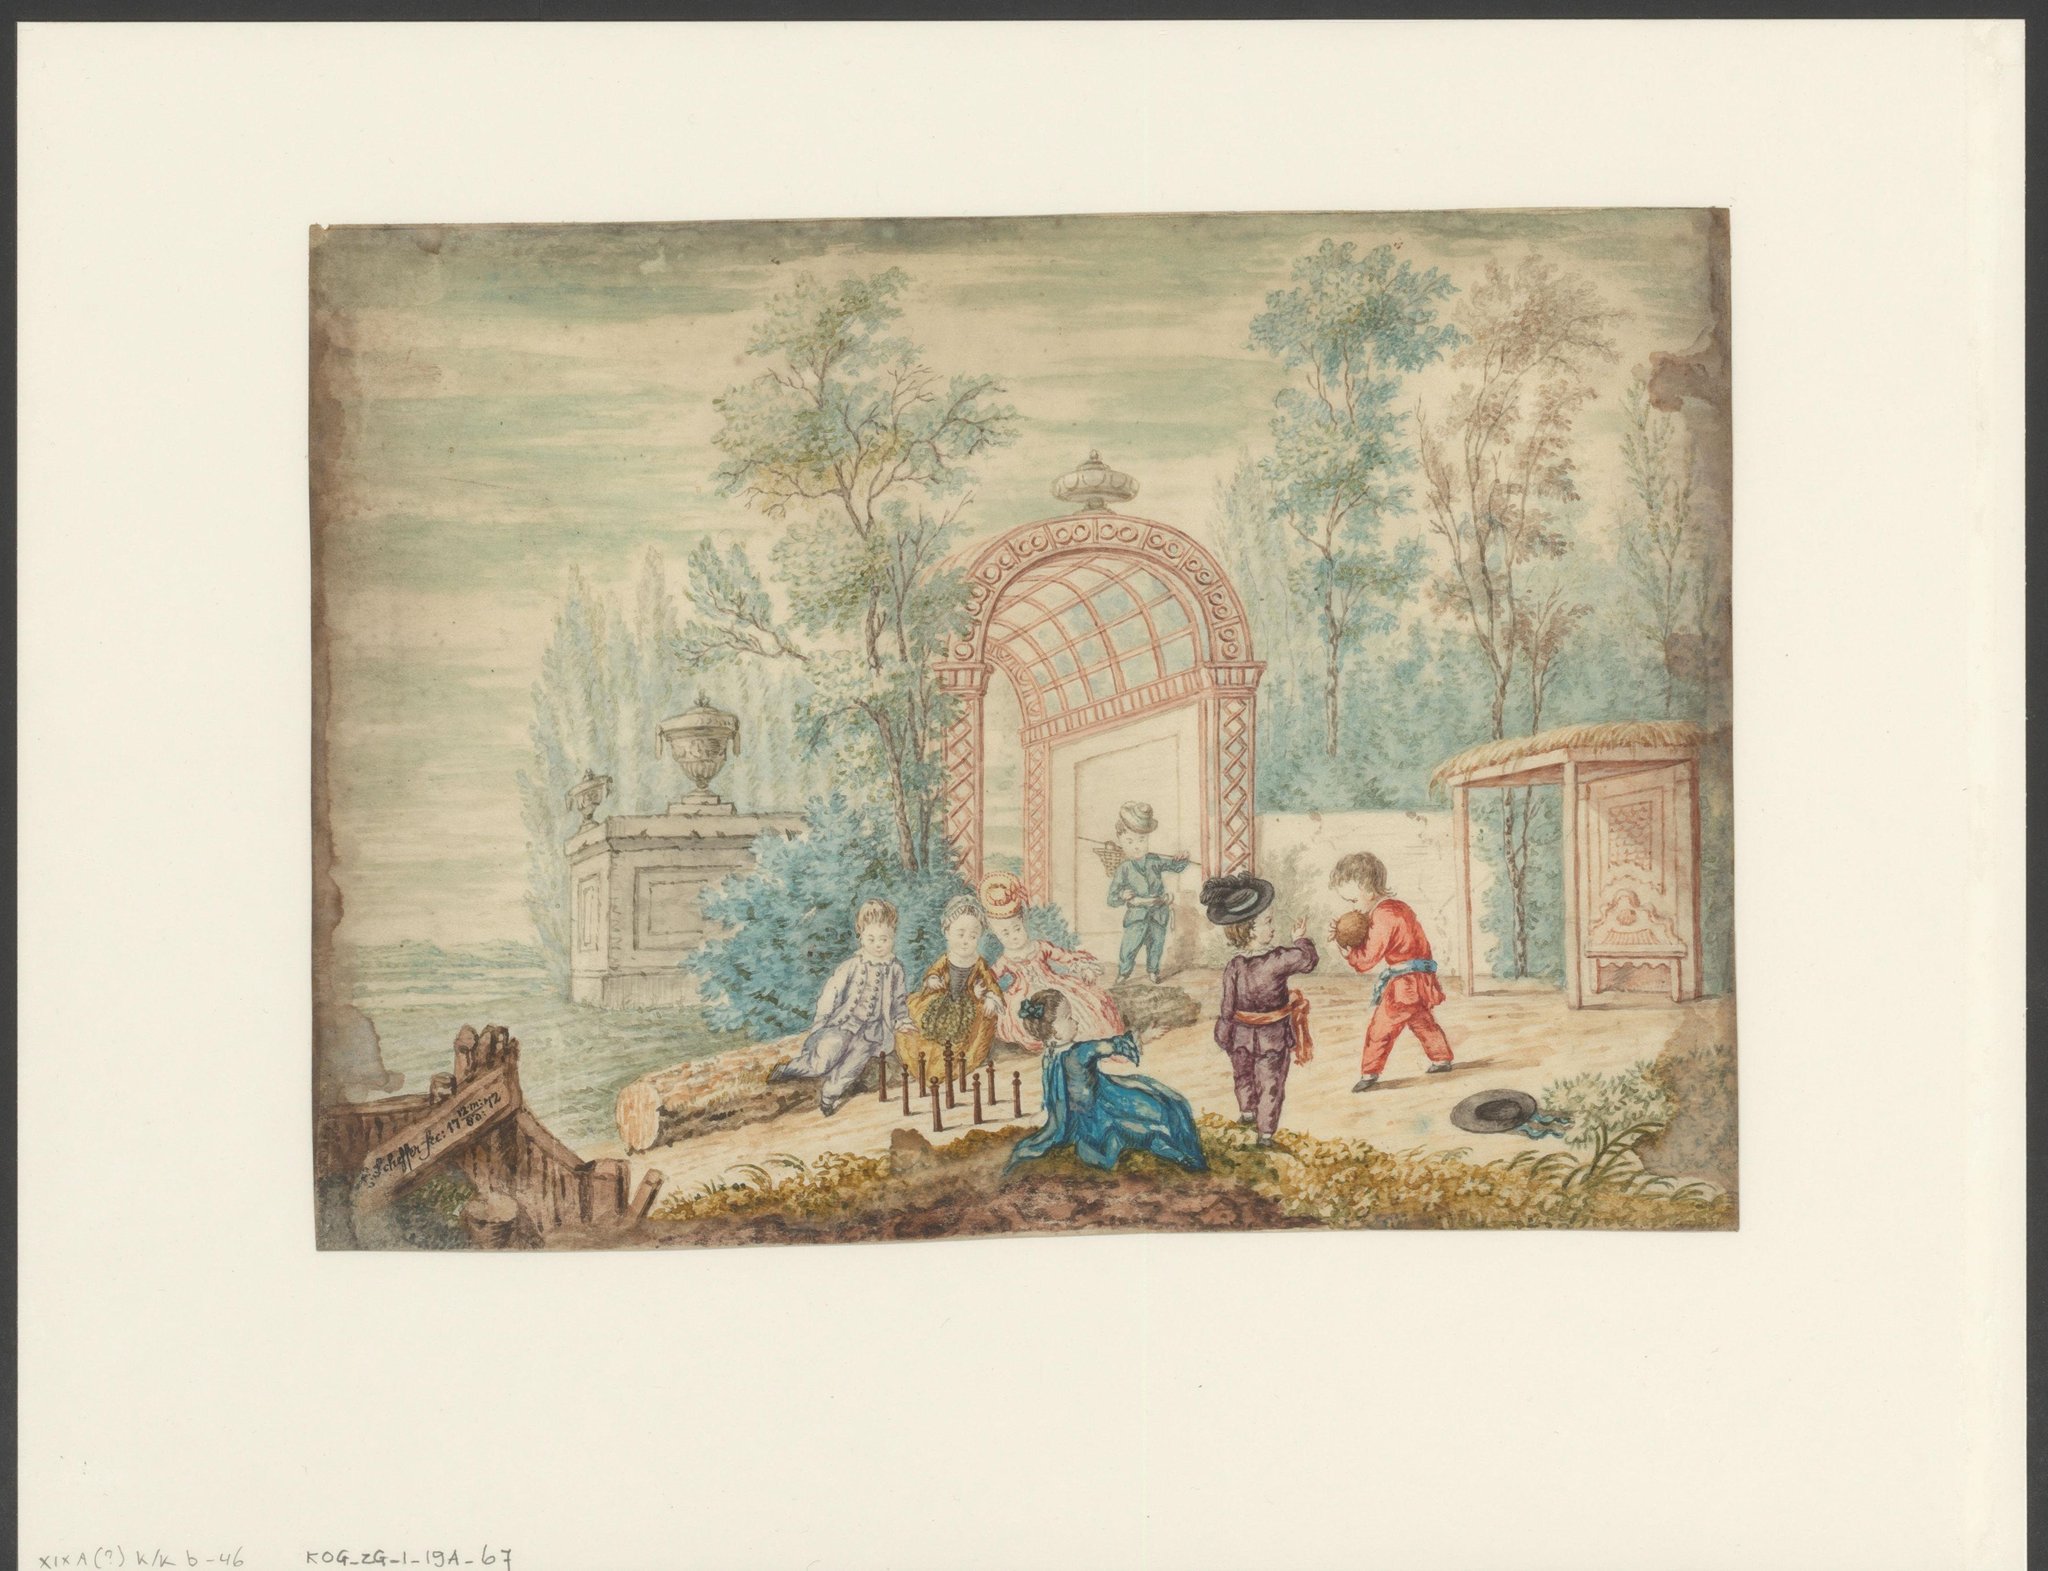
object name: drawing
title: Kinderen spelen een kegelspel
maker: johan bernard scheffer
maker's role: draughtsman, painter, print maker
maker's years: 1765-1809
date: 1772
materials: paper, watercolor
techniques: brush, pen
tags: child, ninepins, skittles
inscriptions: collector's mark: Lugt 1641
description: Onderwerpsrubrieken binnen de Atlas Zeden en Gewoonten: Zeden en Gewoonten in Engeren Zin, Des menschen beging, midden en einde, Kinderleven – Kinderspel en Kinderprenten.